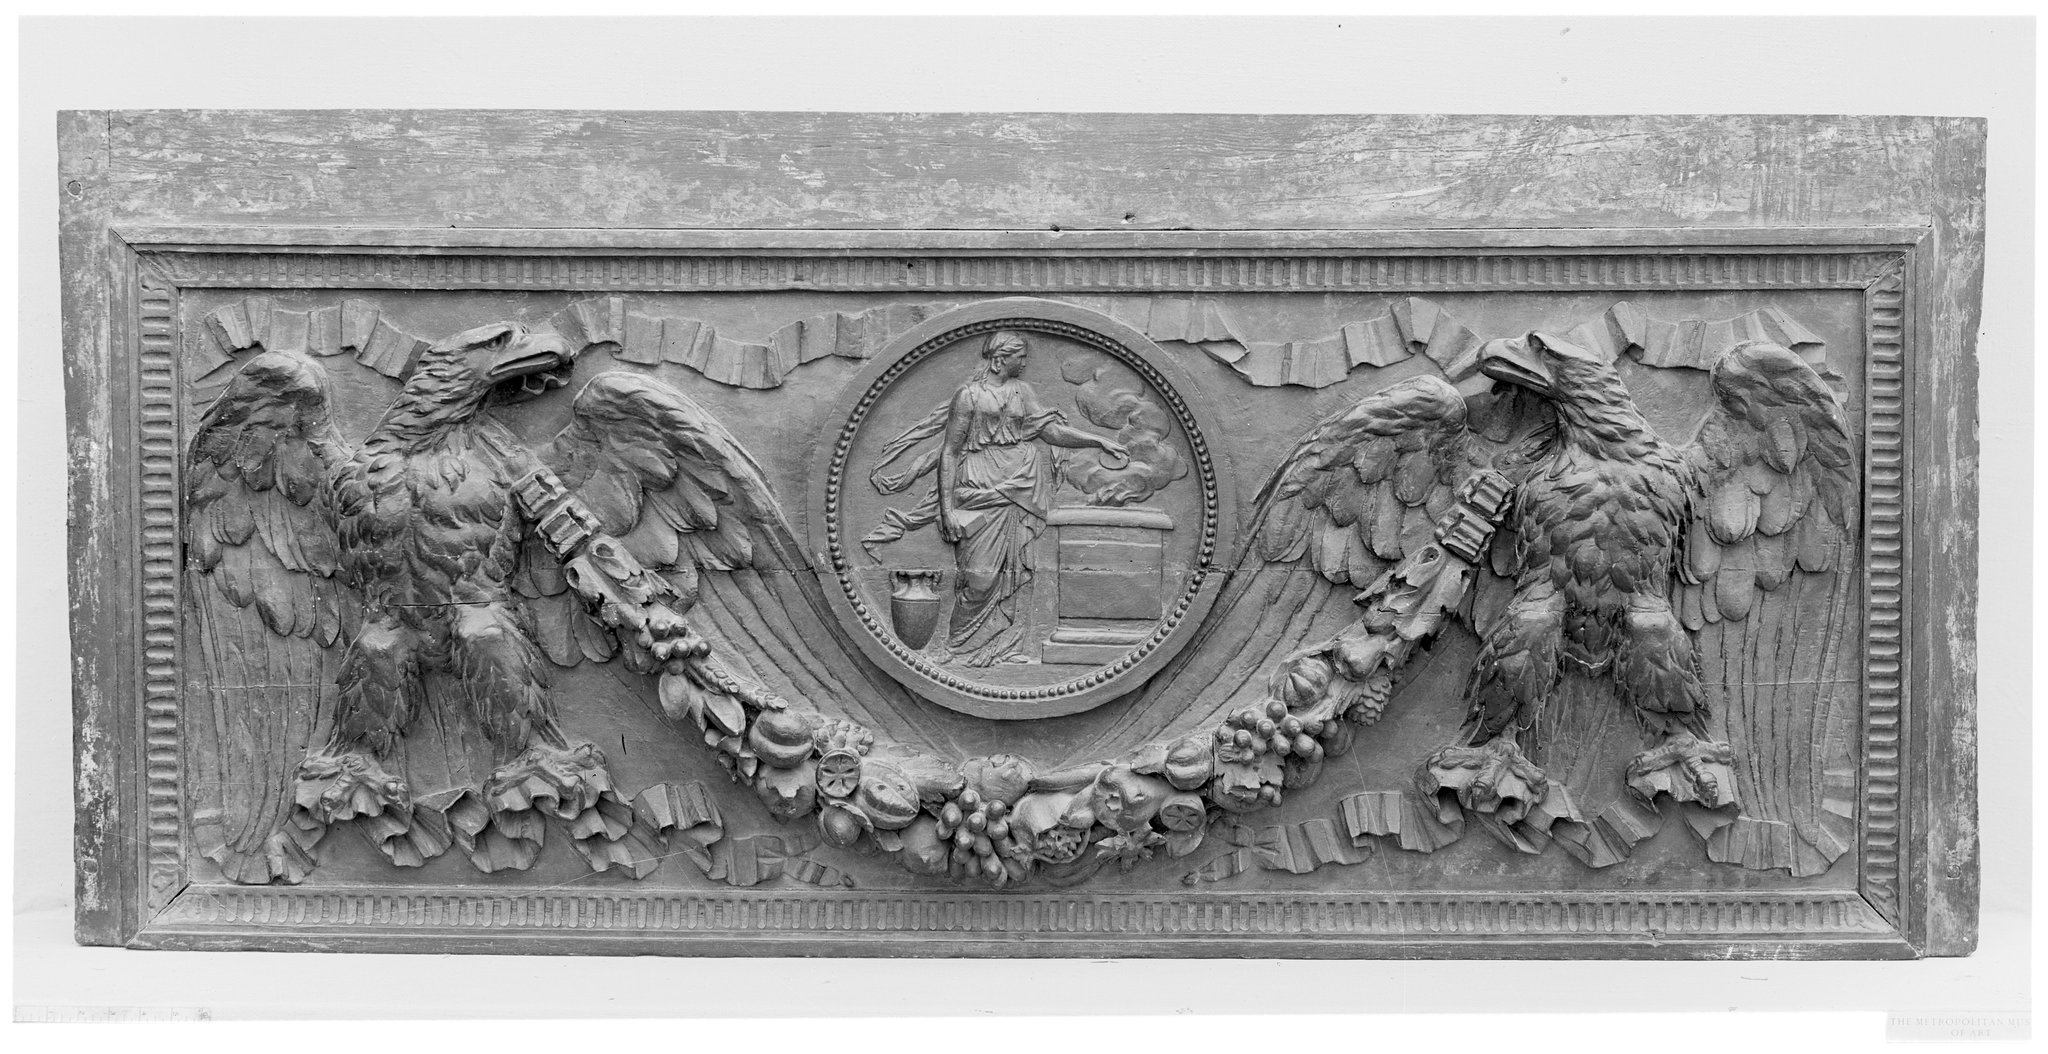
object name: panel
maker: philippe laurent roland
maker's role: modeler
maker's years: 1746-1816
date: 1776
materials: bronze, wood, paint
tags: eagles,women